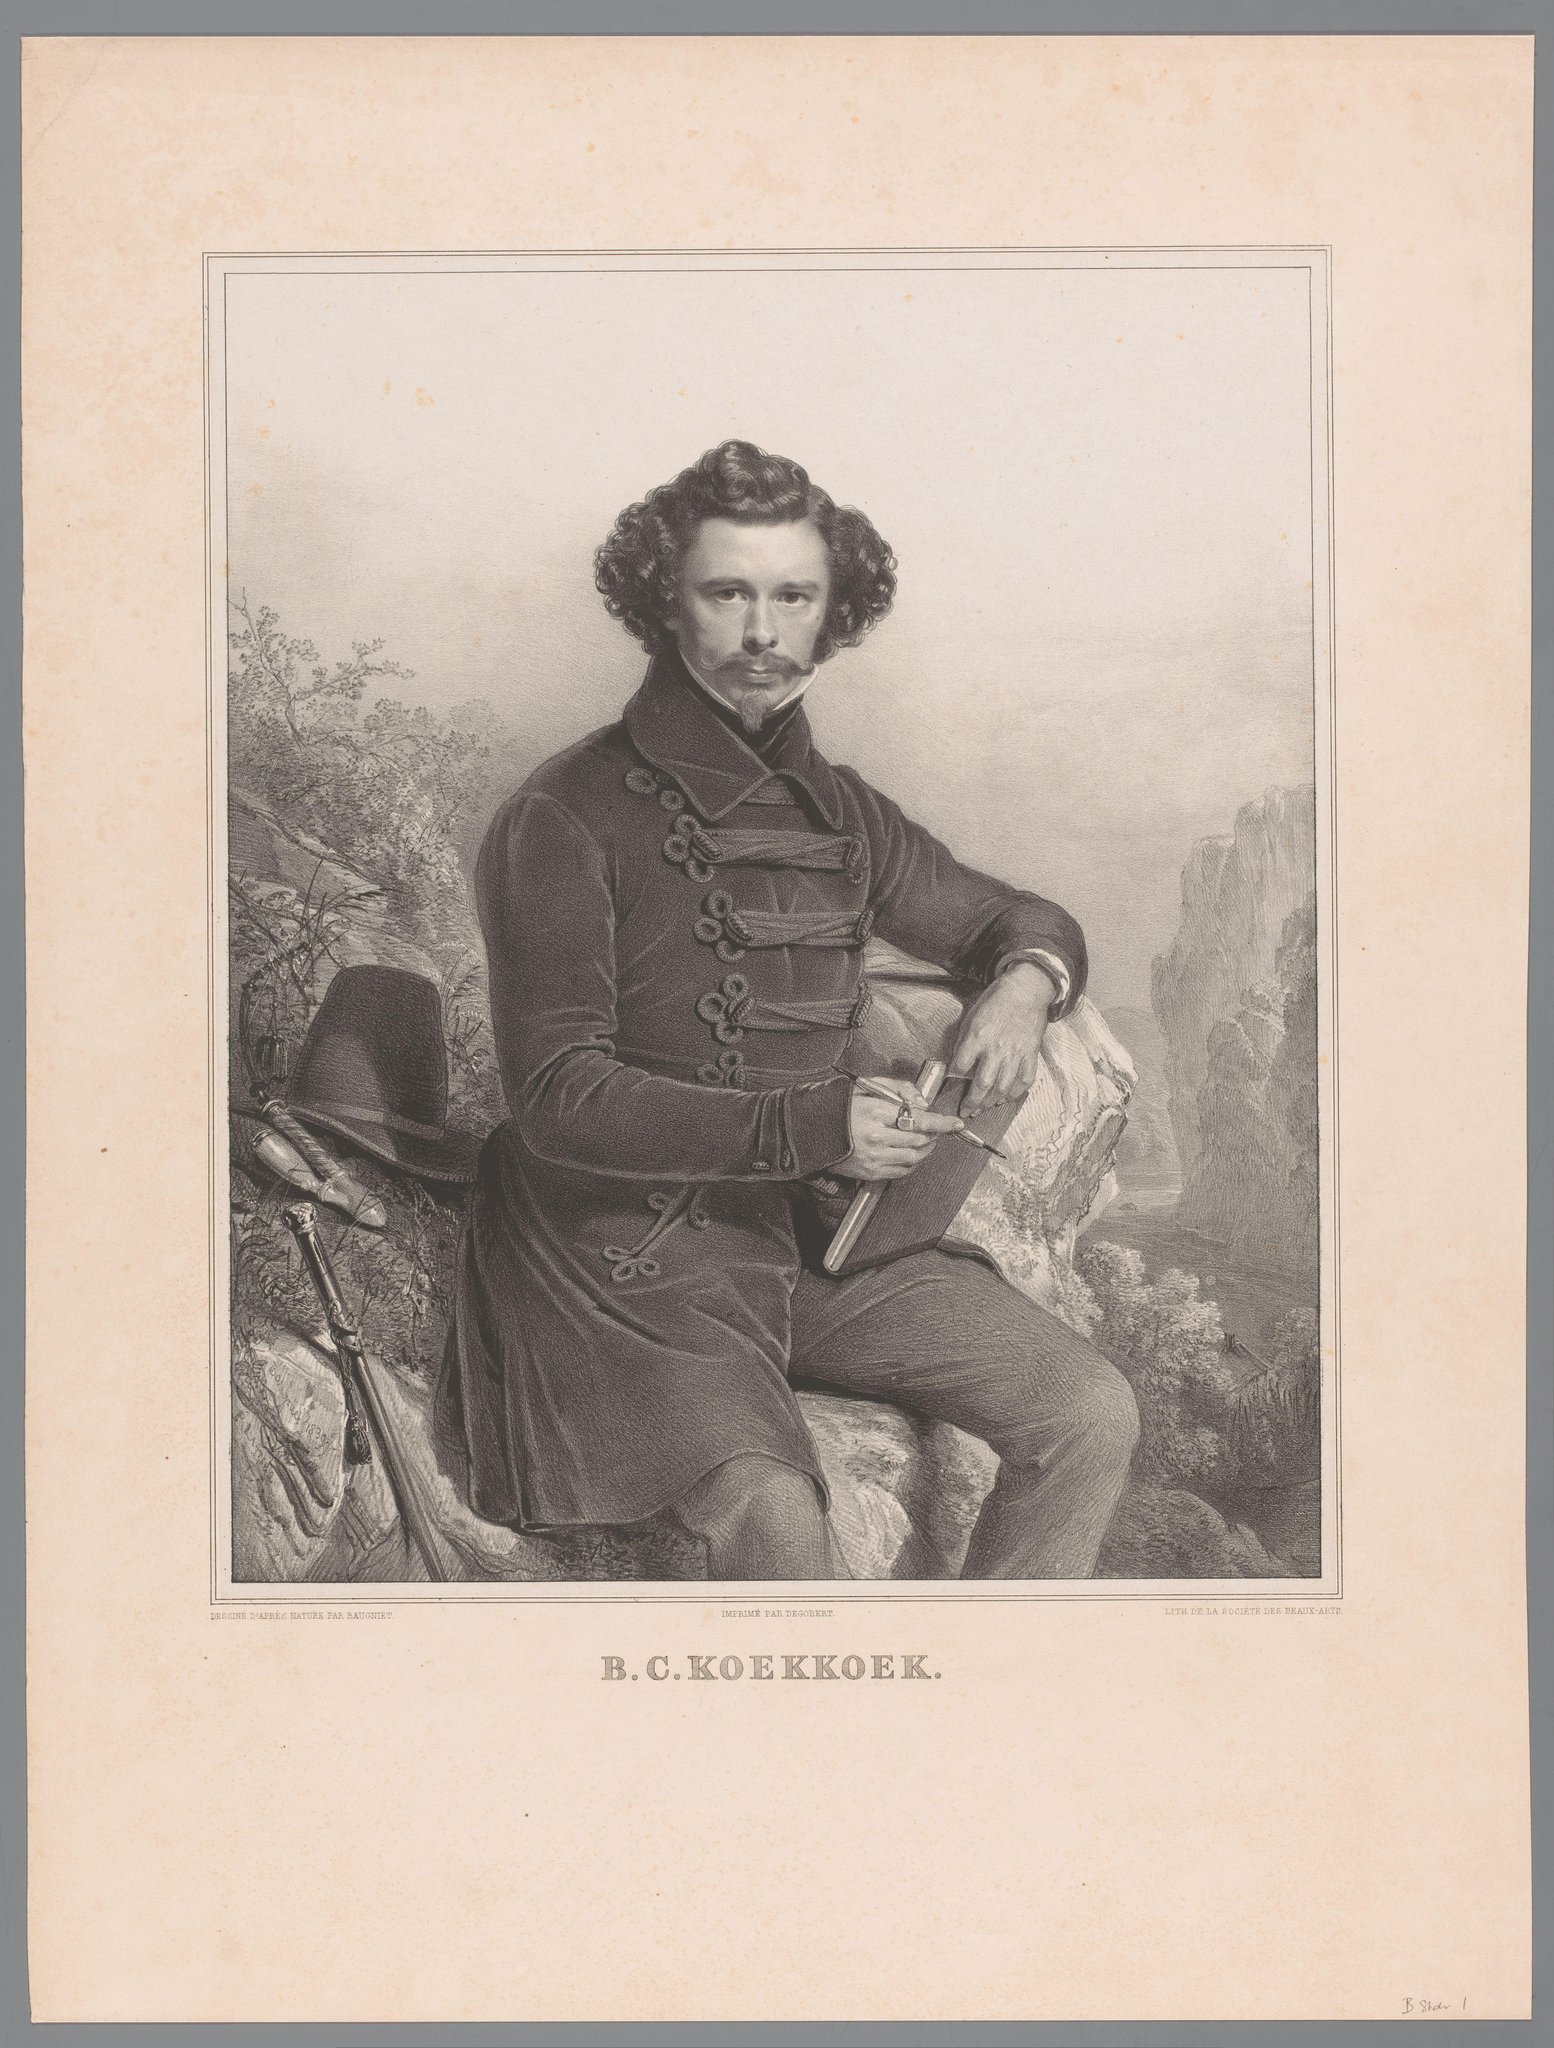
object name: print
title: Portret van Barend Cornelis Koekkoek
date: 1839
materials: paper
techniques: lithograph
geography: brussels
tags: middelburg, cleves, painter, draughtsman, barend cornelis koekkoek, adult man, historical persons, portrait, self-portrait of artist, artist at work, in his workshop - bb - out of doors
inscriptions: date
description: Prent verschenen in: Baugniet, Charles. Les artistes contemporains: portraits lithographiés d'après nature, accompagnés de notices sur la vie et les ouvrages de chacun d'eux. Brussel: De Wasme-Pletinckx, [1836-1840].